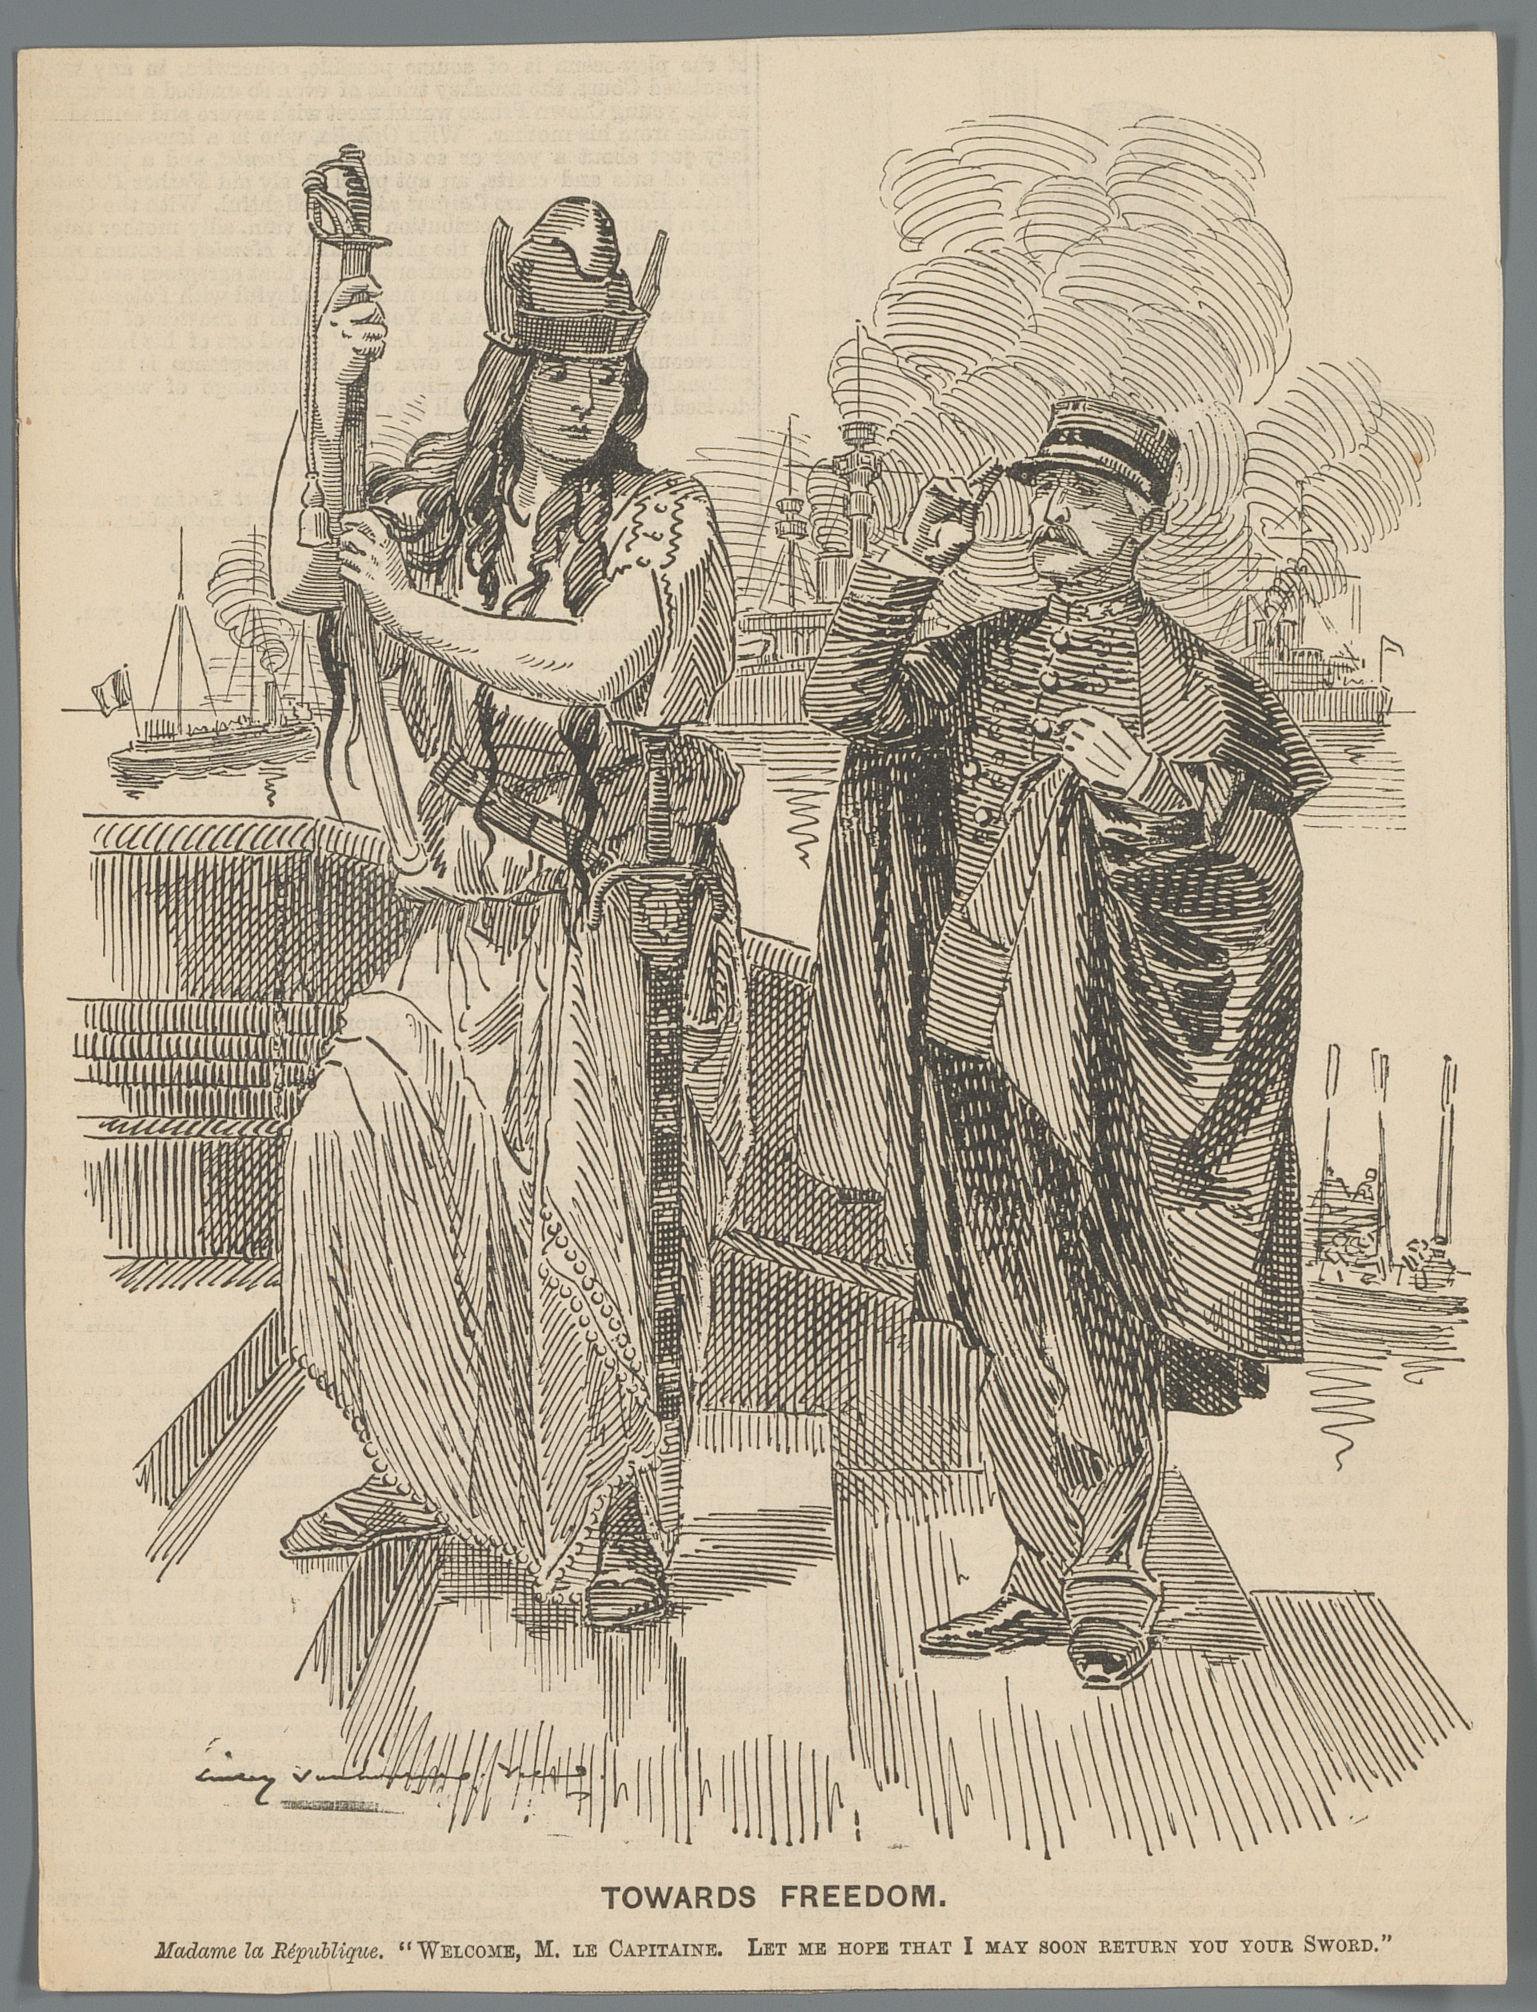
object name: cartoon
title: Rehabilitatie van Dreyfus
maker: edward linley sambourne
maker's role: draughtsman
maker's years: 1844-1910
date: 1899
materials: paper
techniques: line block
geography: england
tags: paris, personifications of countries, nations, states, districts, etc., political caricatures and satires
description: De rehabilitatie van Dreyfus. De Franse maagd hoopt binnenkort Dreyfus zijn zwaard terug te kunnen geven. Spotprent uit het Engelse satirische tijdschrift Punch, ca. 1899.